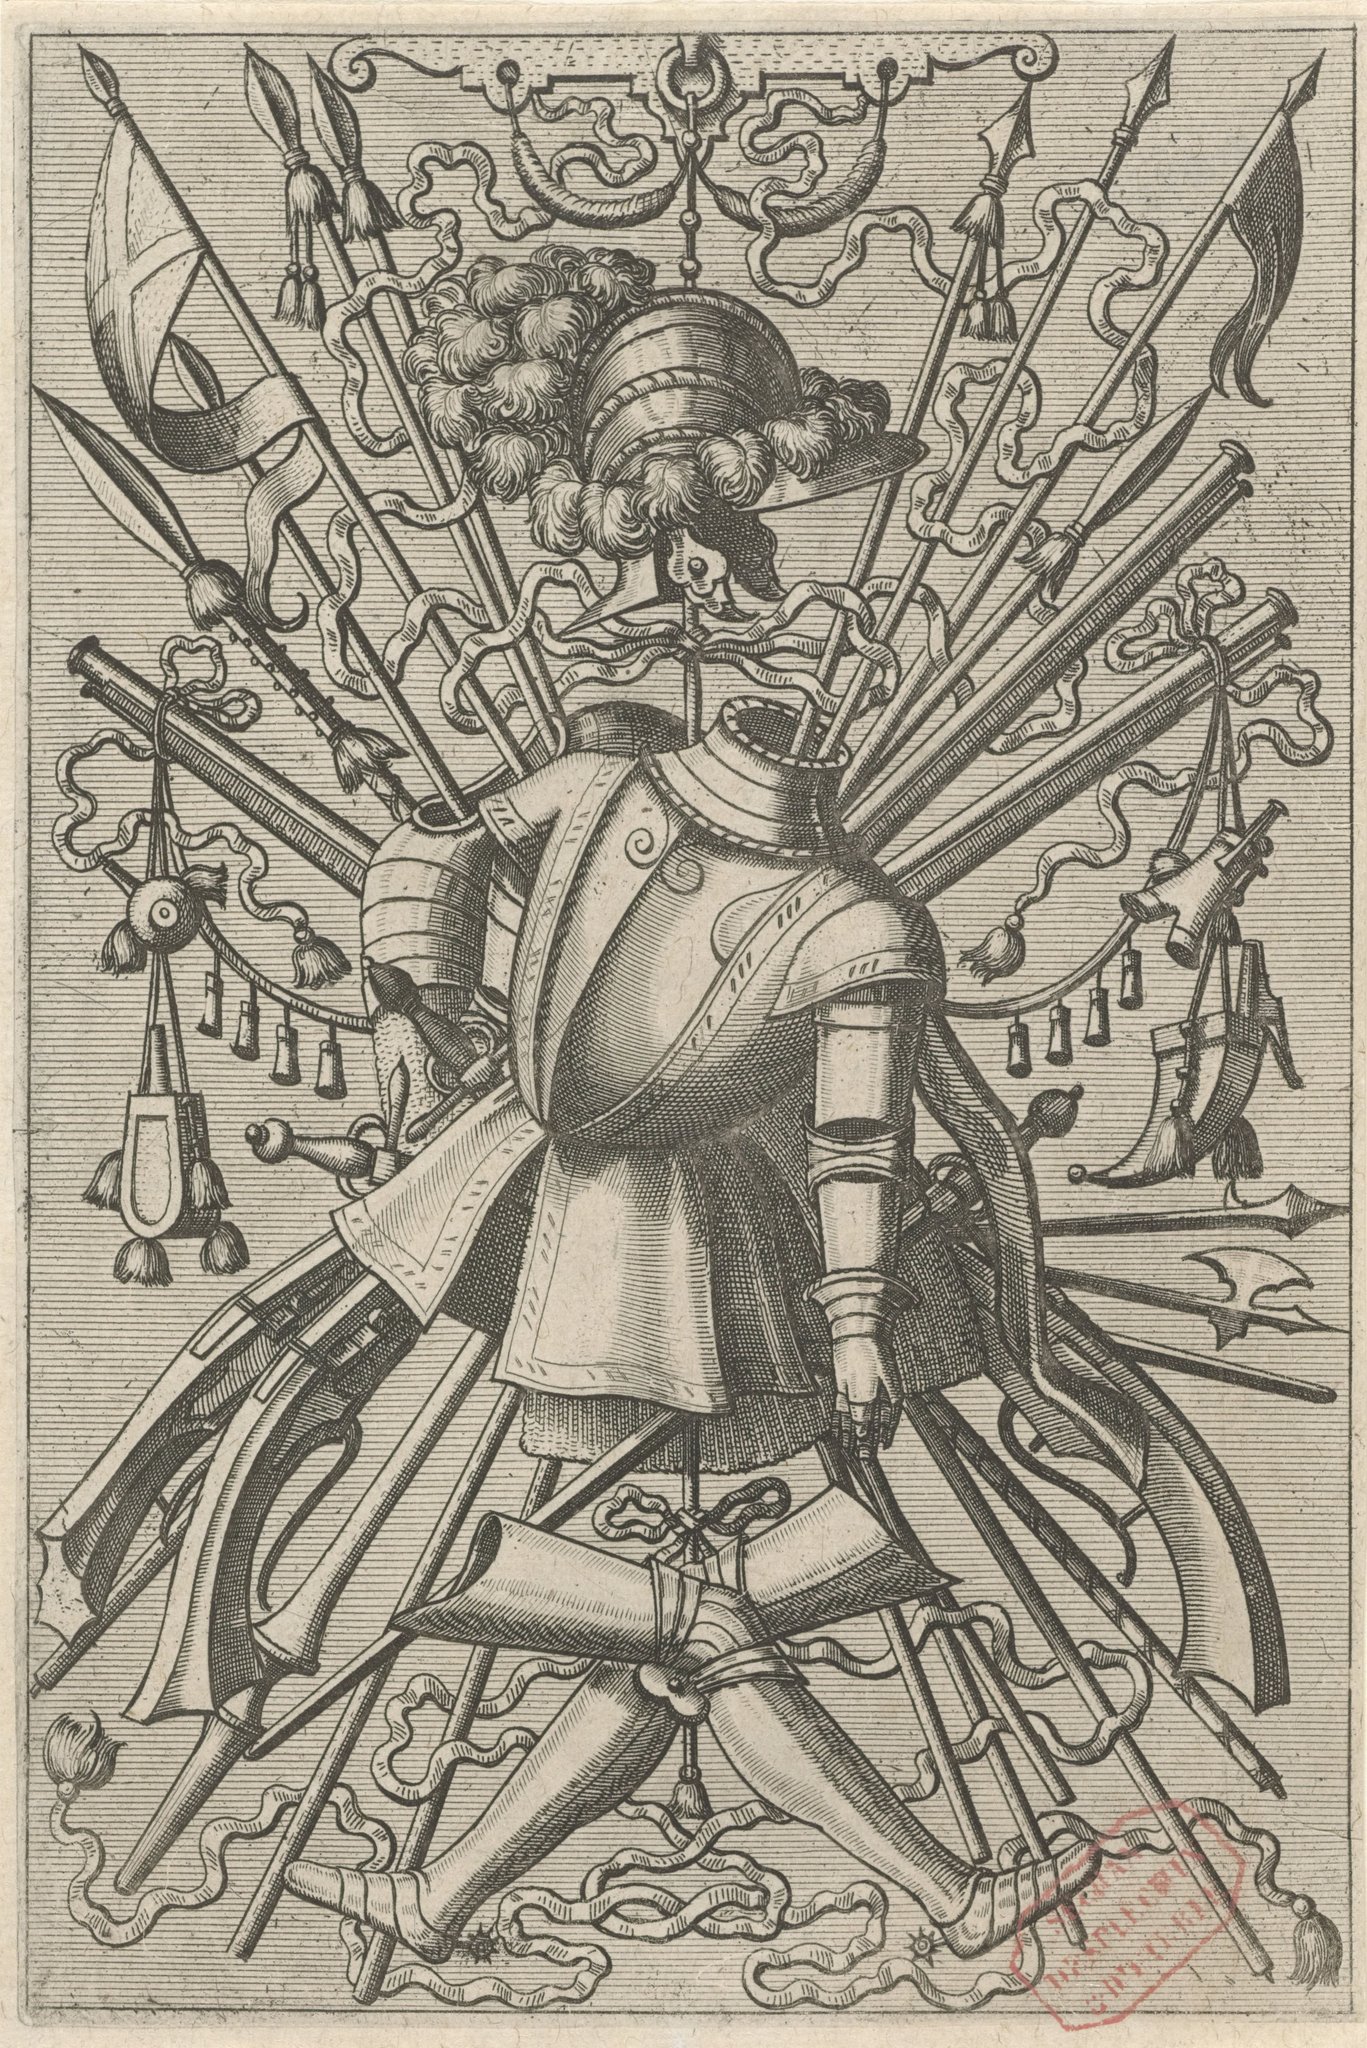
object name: print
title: Vlakdecoraties en friezen met trofeeën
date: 1558-1572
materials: paper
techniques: engraving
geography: netherlands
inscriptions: collector's mark (false): Lugt 2275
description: Een helm, een maliënkolder, gebogen musketten en een kruithoorn met patroontas en kogeltangetje. Uit serie, bestaande uit een titelblad en 16 bladen.